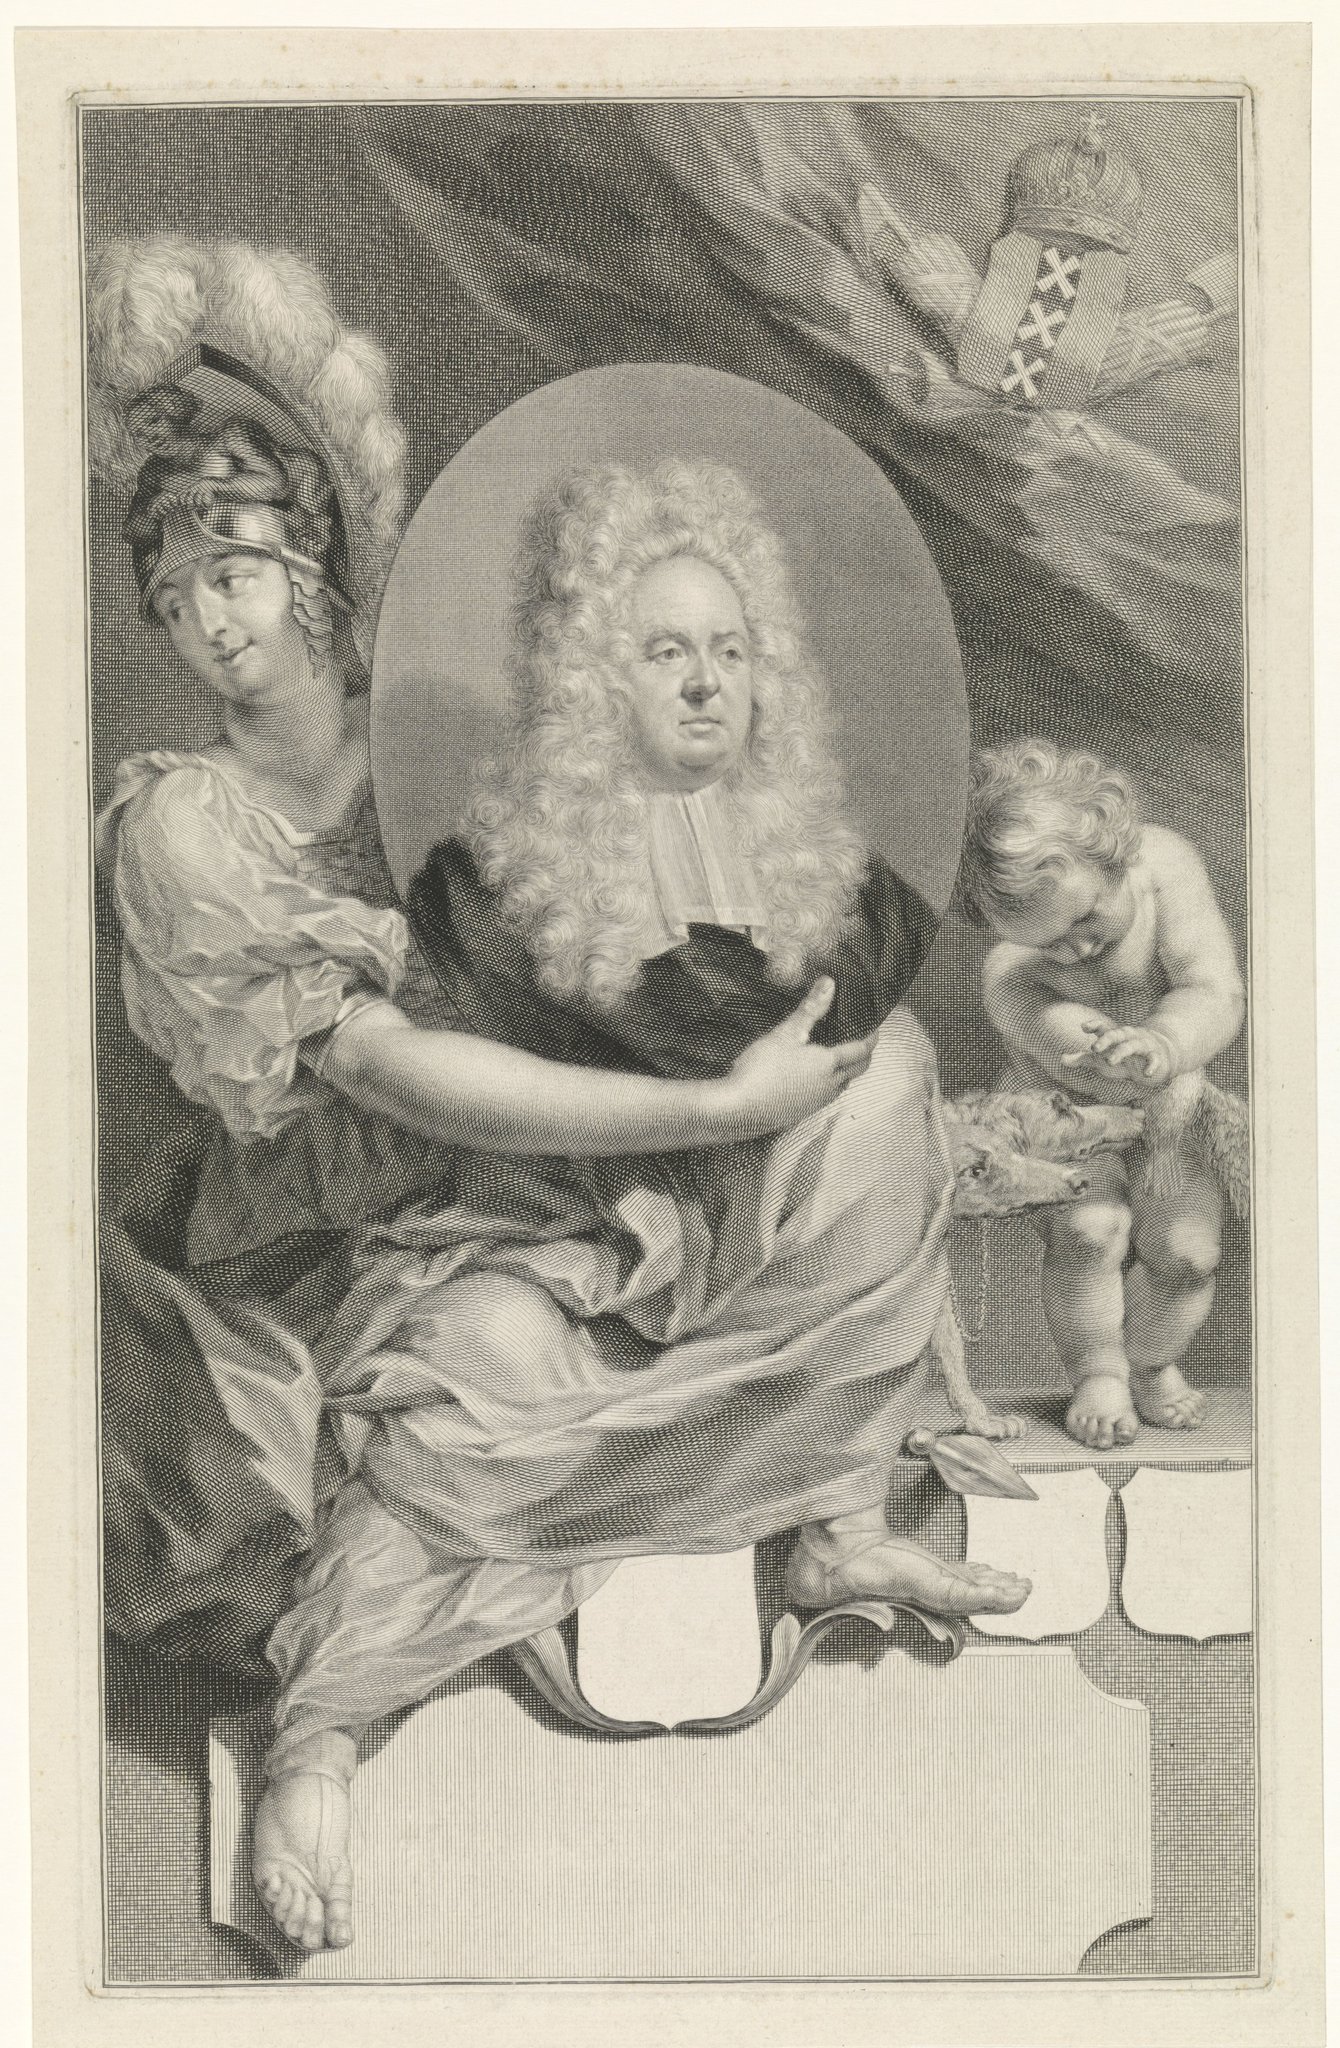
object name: print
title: Portret van Jan Six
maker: jacob houbraken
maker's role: draughtsman, print maker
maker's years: 1698-1780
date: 1708-1780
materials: paper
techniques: engraving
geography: amsterdam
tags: mayor, jan six (1668-1750), specific aspects, allegorical aspects of minerva; minerva as patroness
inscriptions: collector's mark: Lugt 240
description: Buste van Jan Six in een ovaal, dat wordt vastgehouden door Minerva. Rechts een putto, aaiend over de koppen van de twee honden. Op de achtergrond een gordijn en het gekroonde stadswapen van Amsterdam met fasces. Op de sokkel waarop Minerva is gezeten drie oningevulde wapens en een leeg cartouche.